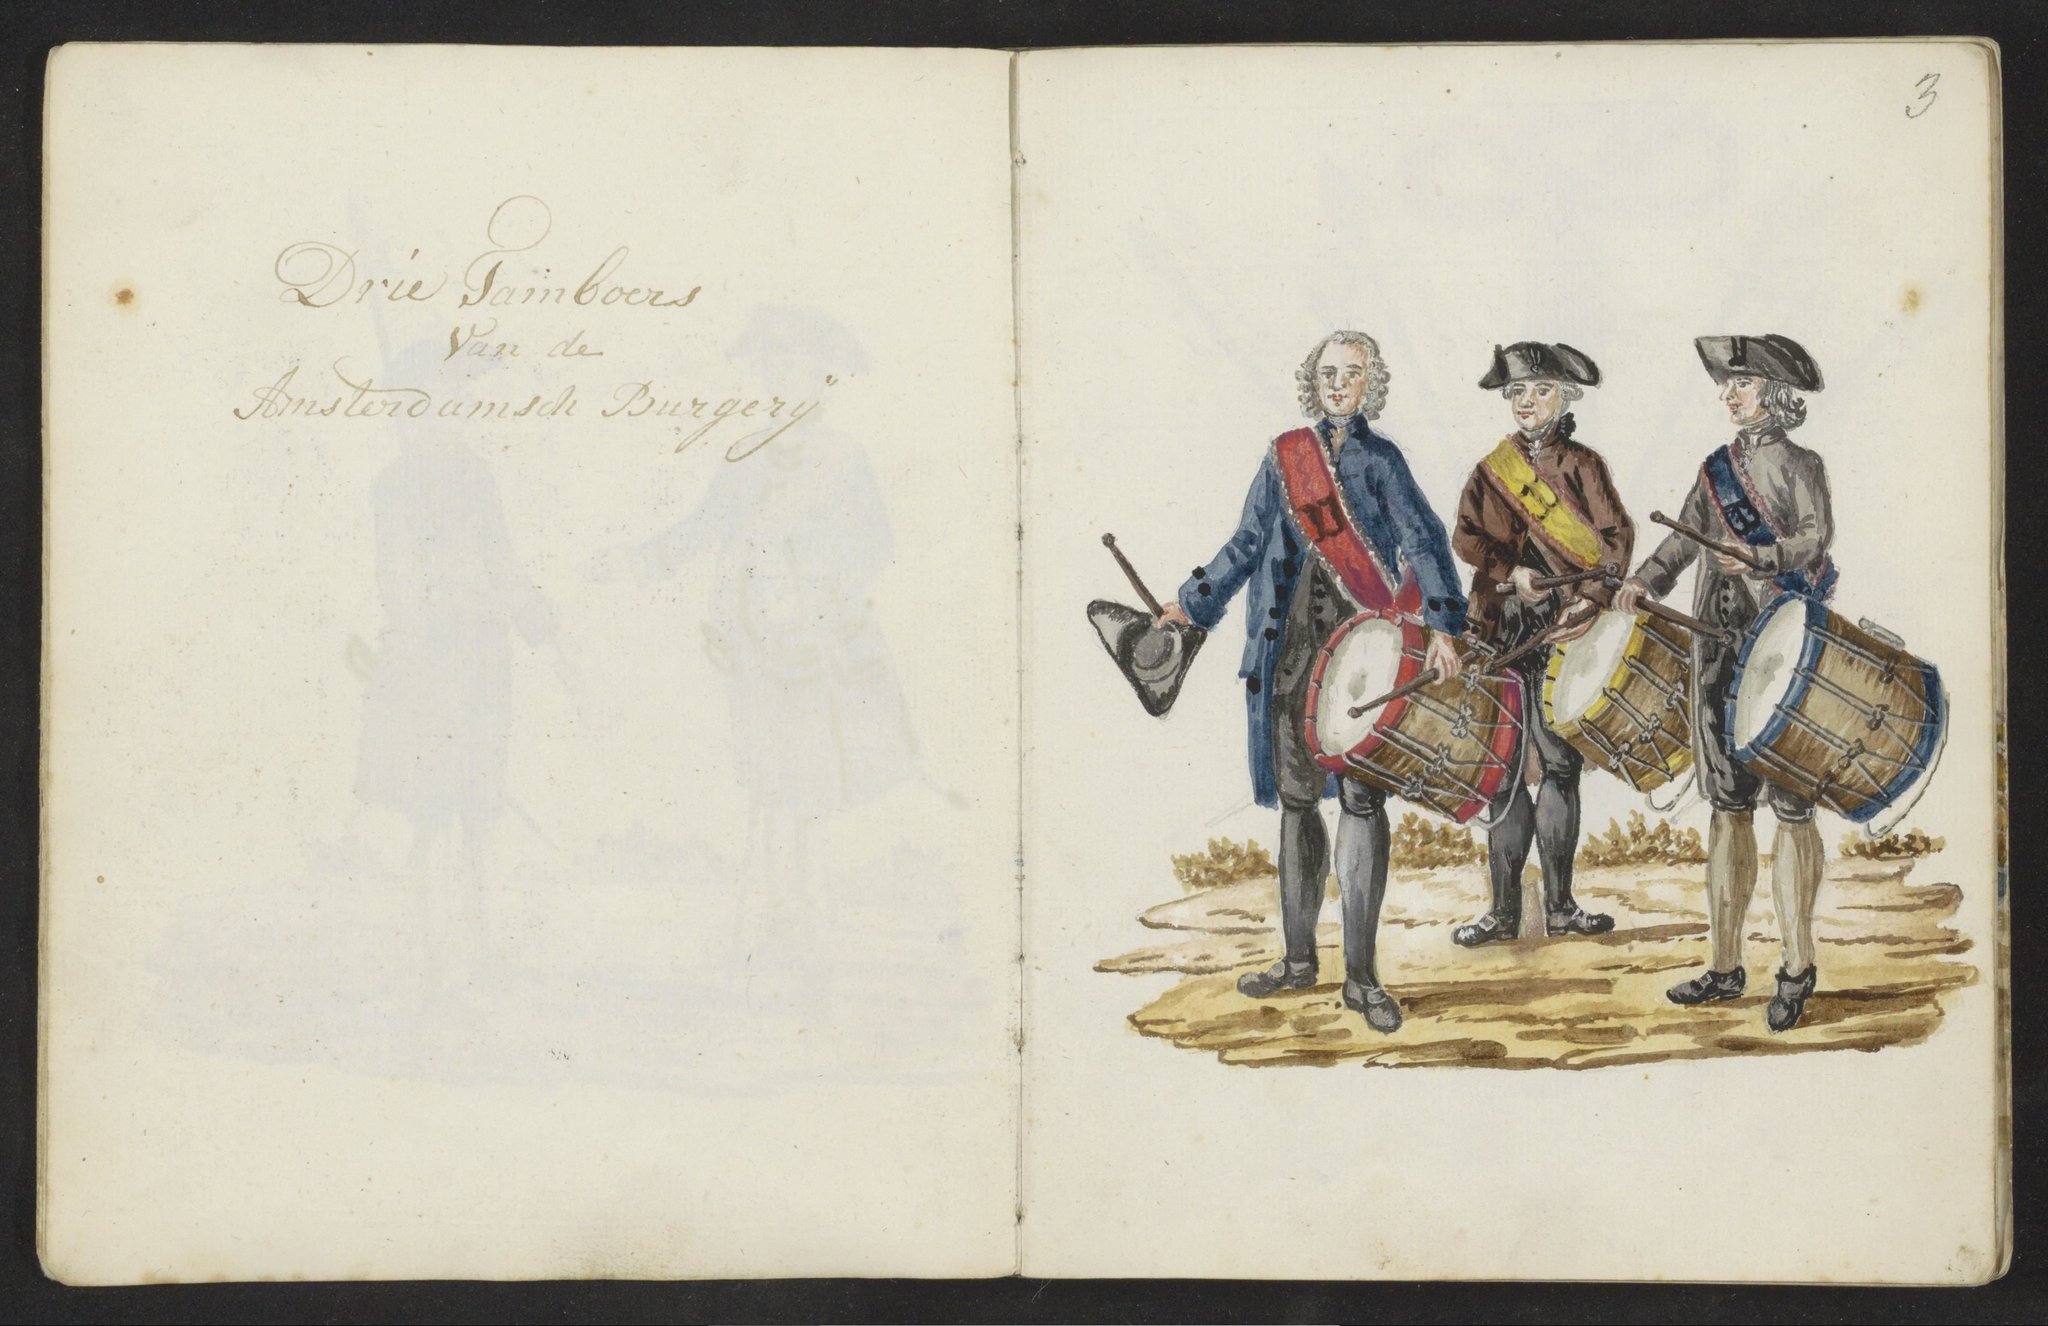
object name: drawing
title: Uniformen van tamboers van de Amsterdamse schutterij van 1770-1783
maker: s.g. casten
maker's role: draughtsman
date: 1795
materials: paper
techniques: writing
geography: amsterdam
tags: (military) uniforms (+ citizen soldiery, civil guard, citizen militia), military music (+ citizen soldiery, civil guard, citizen militia), patriots (1780-1795)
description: De uniformen van drie tamboers van de Amsterdamse schutterij. Onderdeel van het hoofdstuk over de oude Amsterdamse schutterij van 1770-1783. In het schetsboek met gekleurde tekeningen van de uniformen van militairen en leden van de schutterij uit de periode 1770 tot 1795-1796.